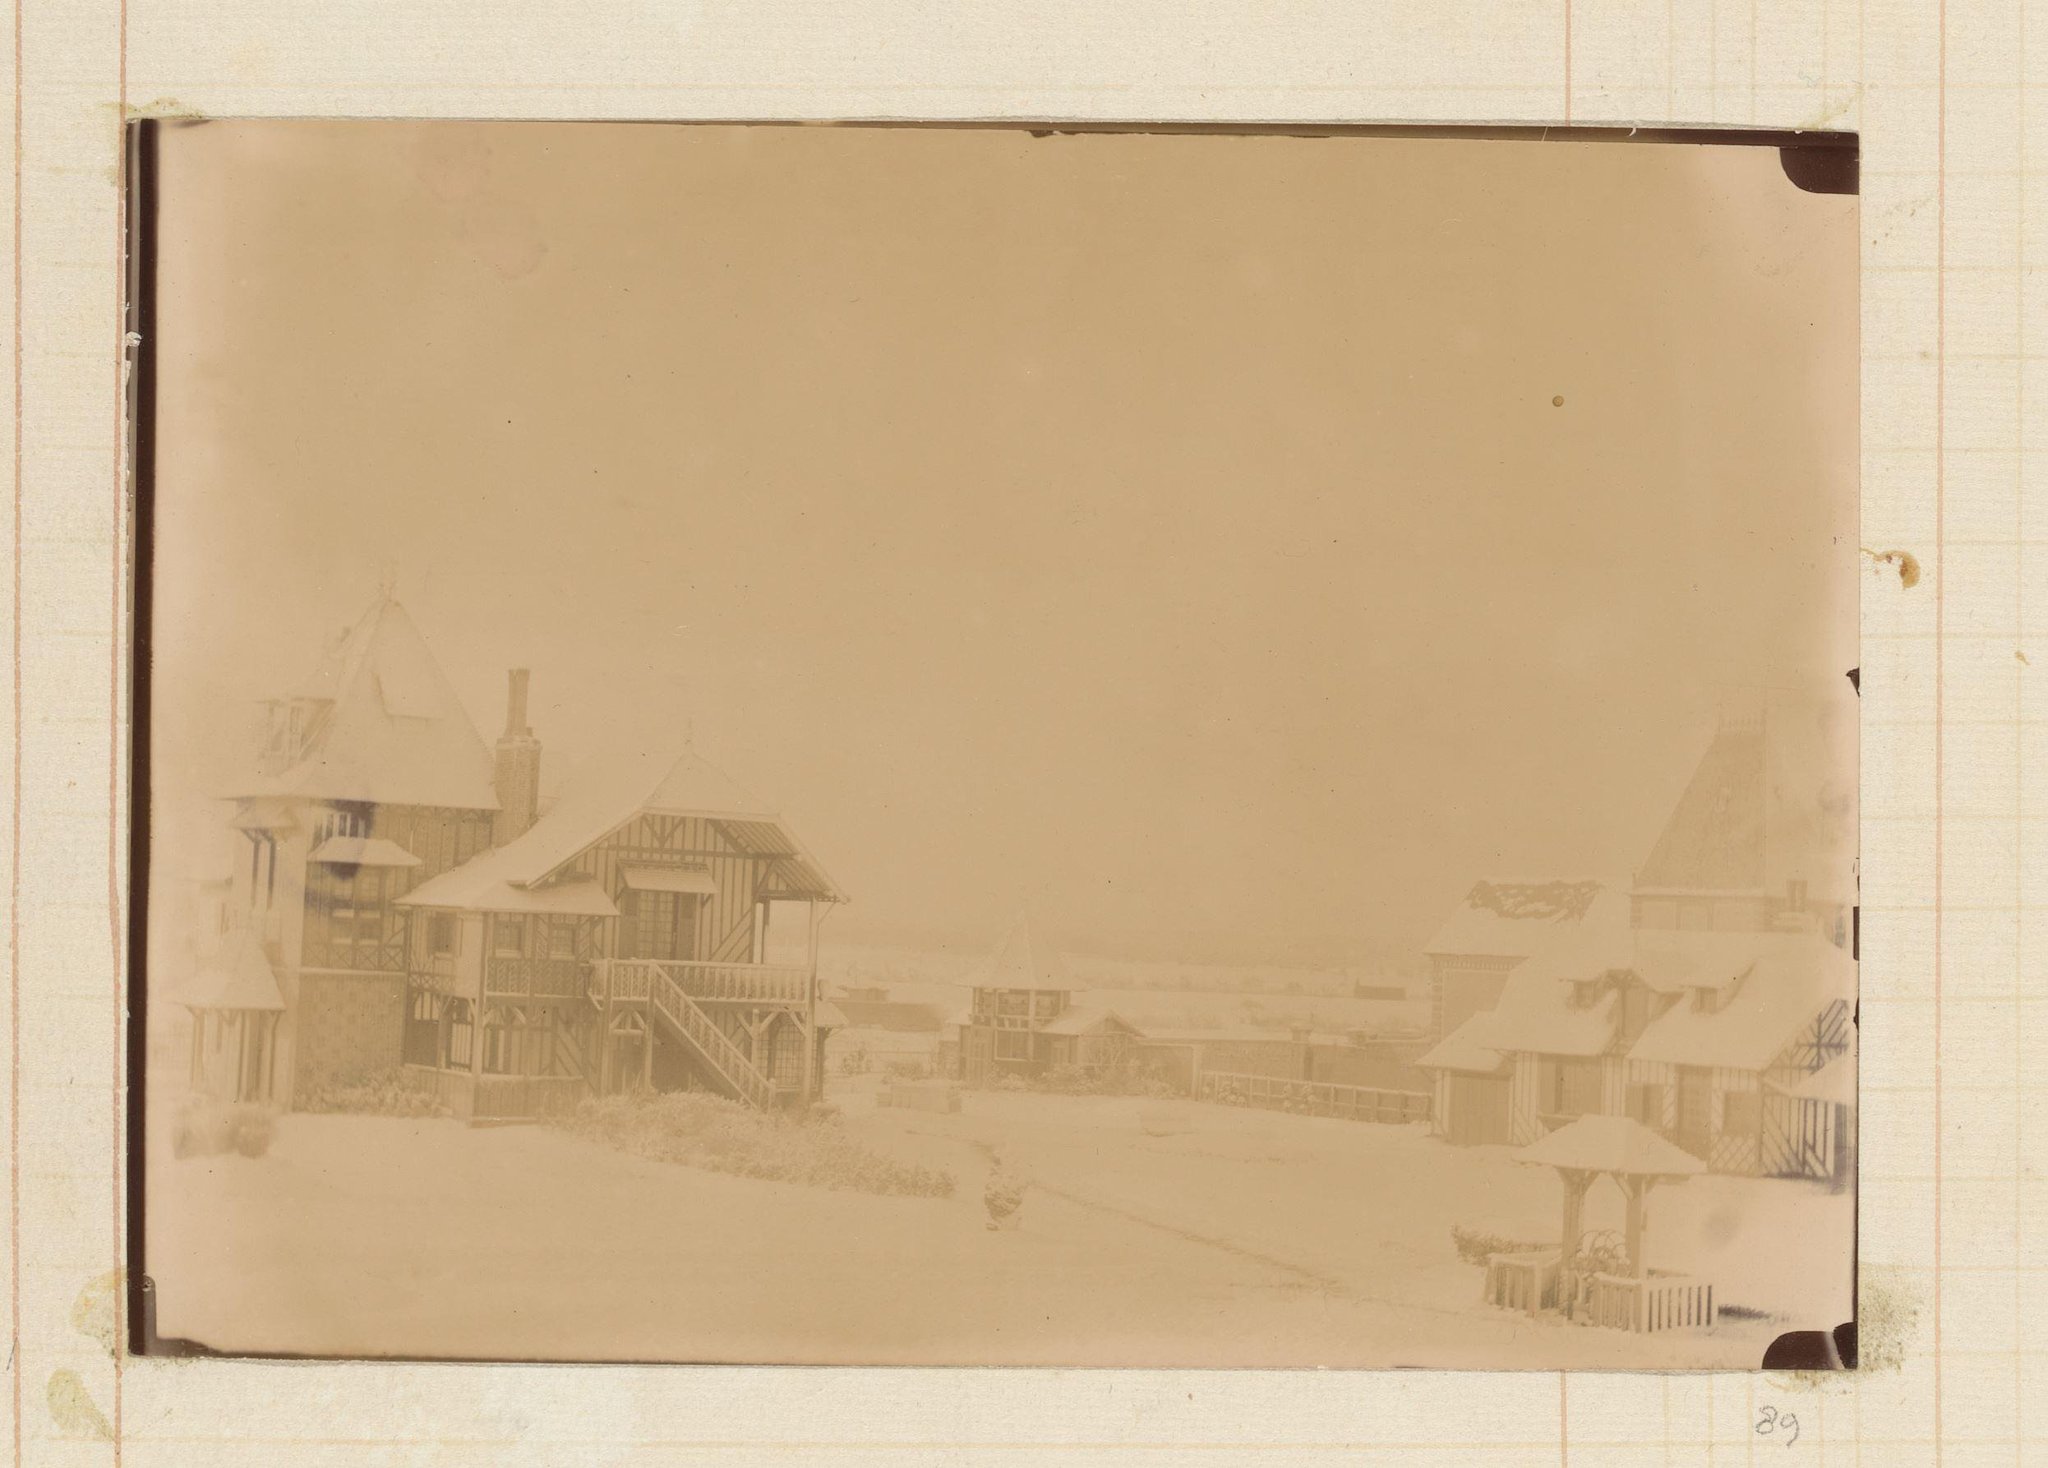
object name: photograph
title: Vakwerkhuizen in de sneeuw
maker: Anonymous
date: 1880-1900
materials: paper, photographic support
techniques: gelatin silver print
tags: rural housing, e.g. country-house, villa, cottage, snow